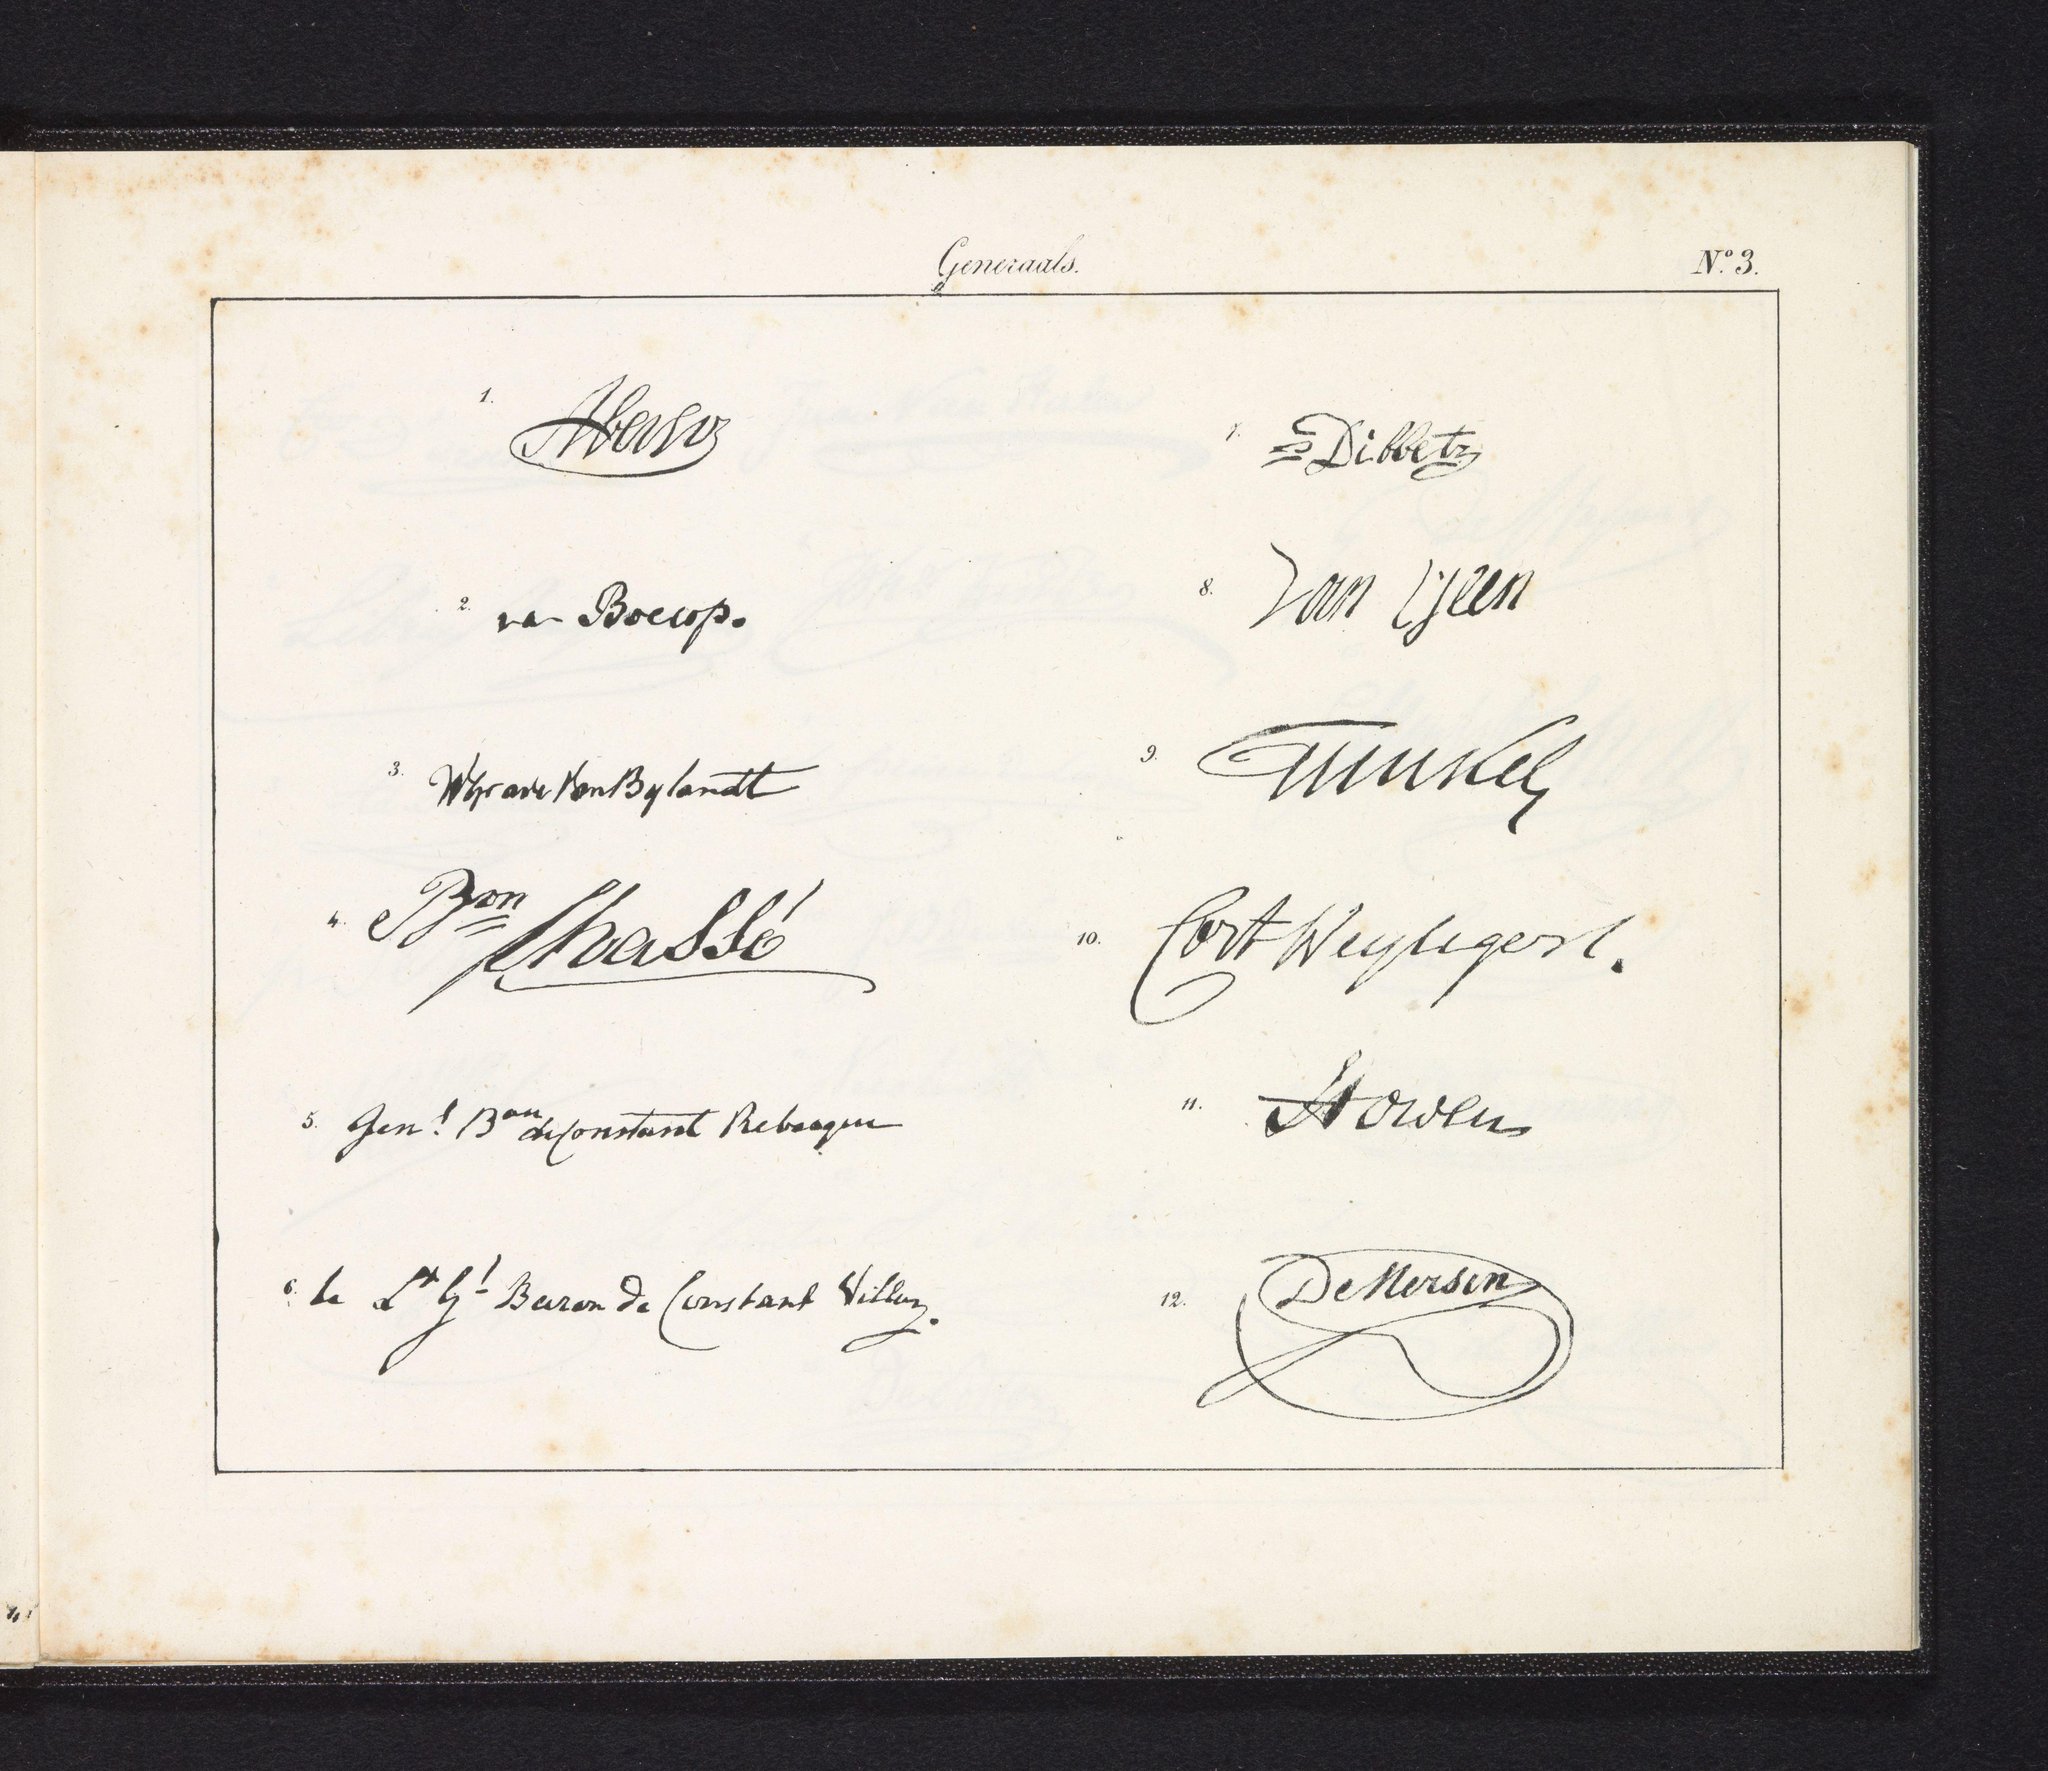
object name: print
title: Generaals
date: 1830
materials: paper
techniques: lithograph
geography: amsterdam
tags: handwriting, written text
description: Facsimiles van de handtekeningen van twaalf generaals in het Nederlandse leger. Illustratie in een bundel van twee cahiers met facsimiles van de handtekeningen van hoofdrolspelers in de Belgische Revolutie in 1830.